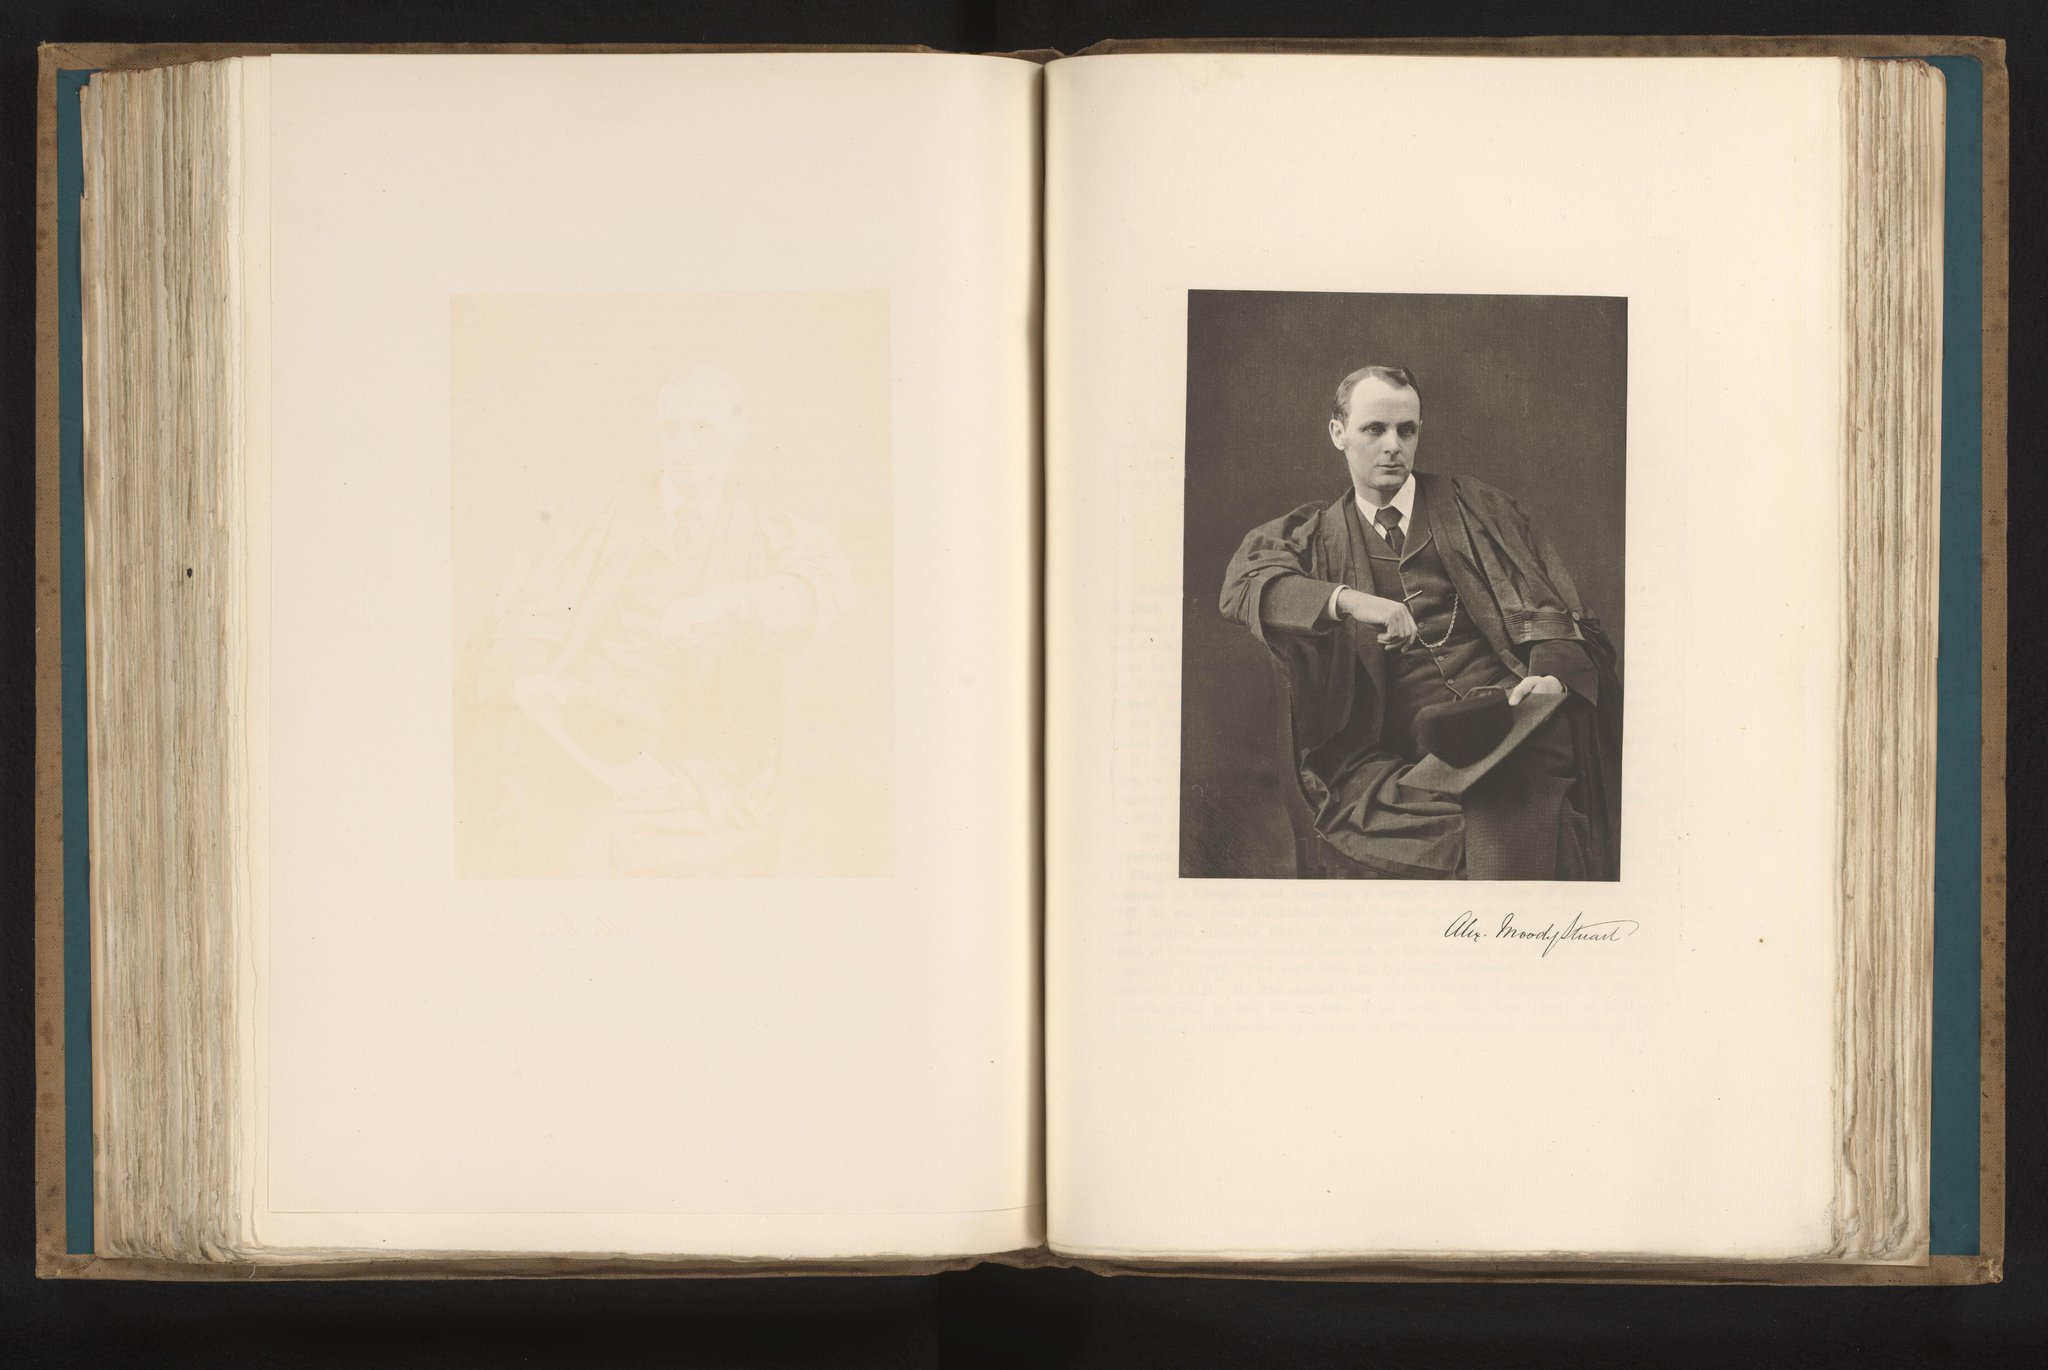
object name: page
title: Alex. Moody Stuart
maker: Anonymous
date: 1886-1891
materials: paper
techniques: photoaquatint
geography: glasgow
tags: minister ~ government, historical persons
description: Prent op tweede ongenummerde pagina na pagina 97.